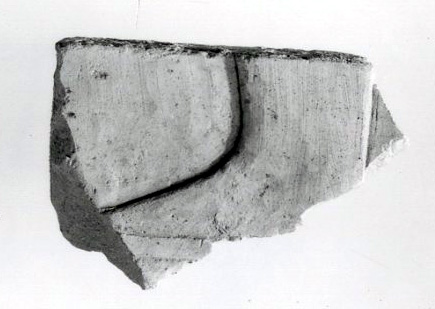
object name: relief fragment, tomb of meketre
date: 1981-1975 BCE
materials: limestone, paint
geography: egypt